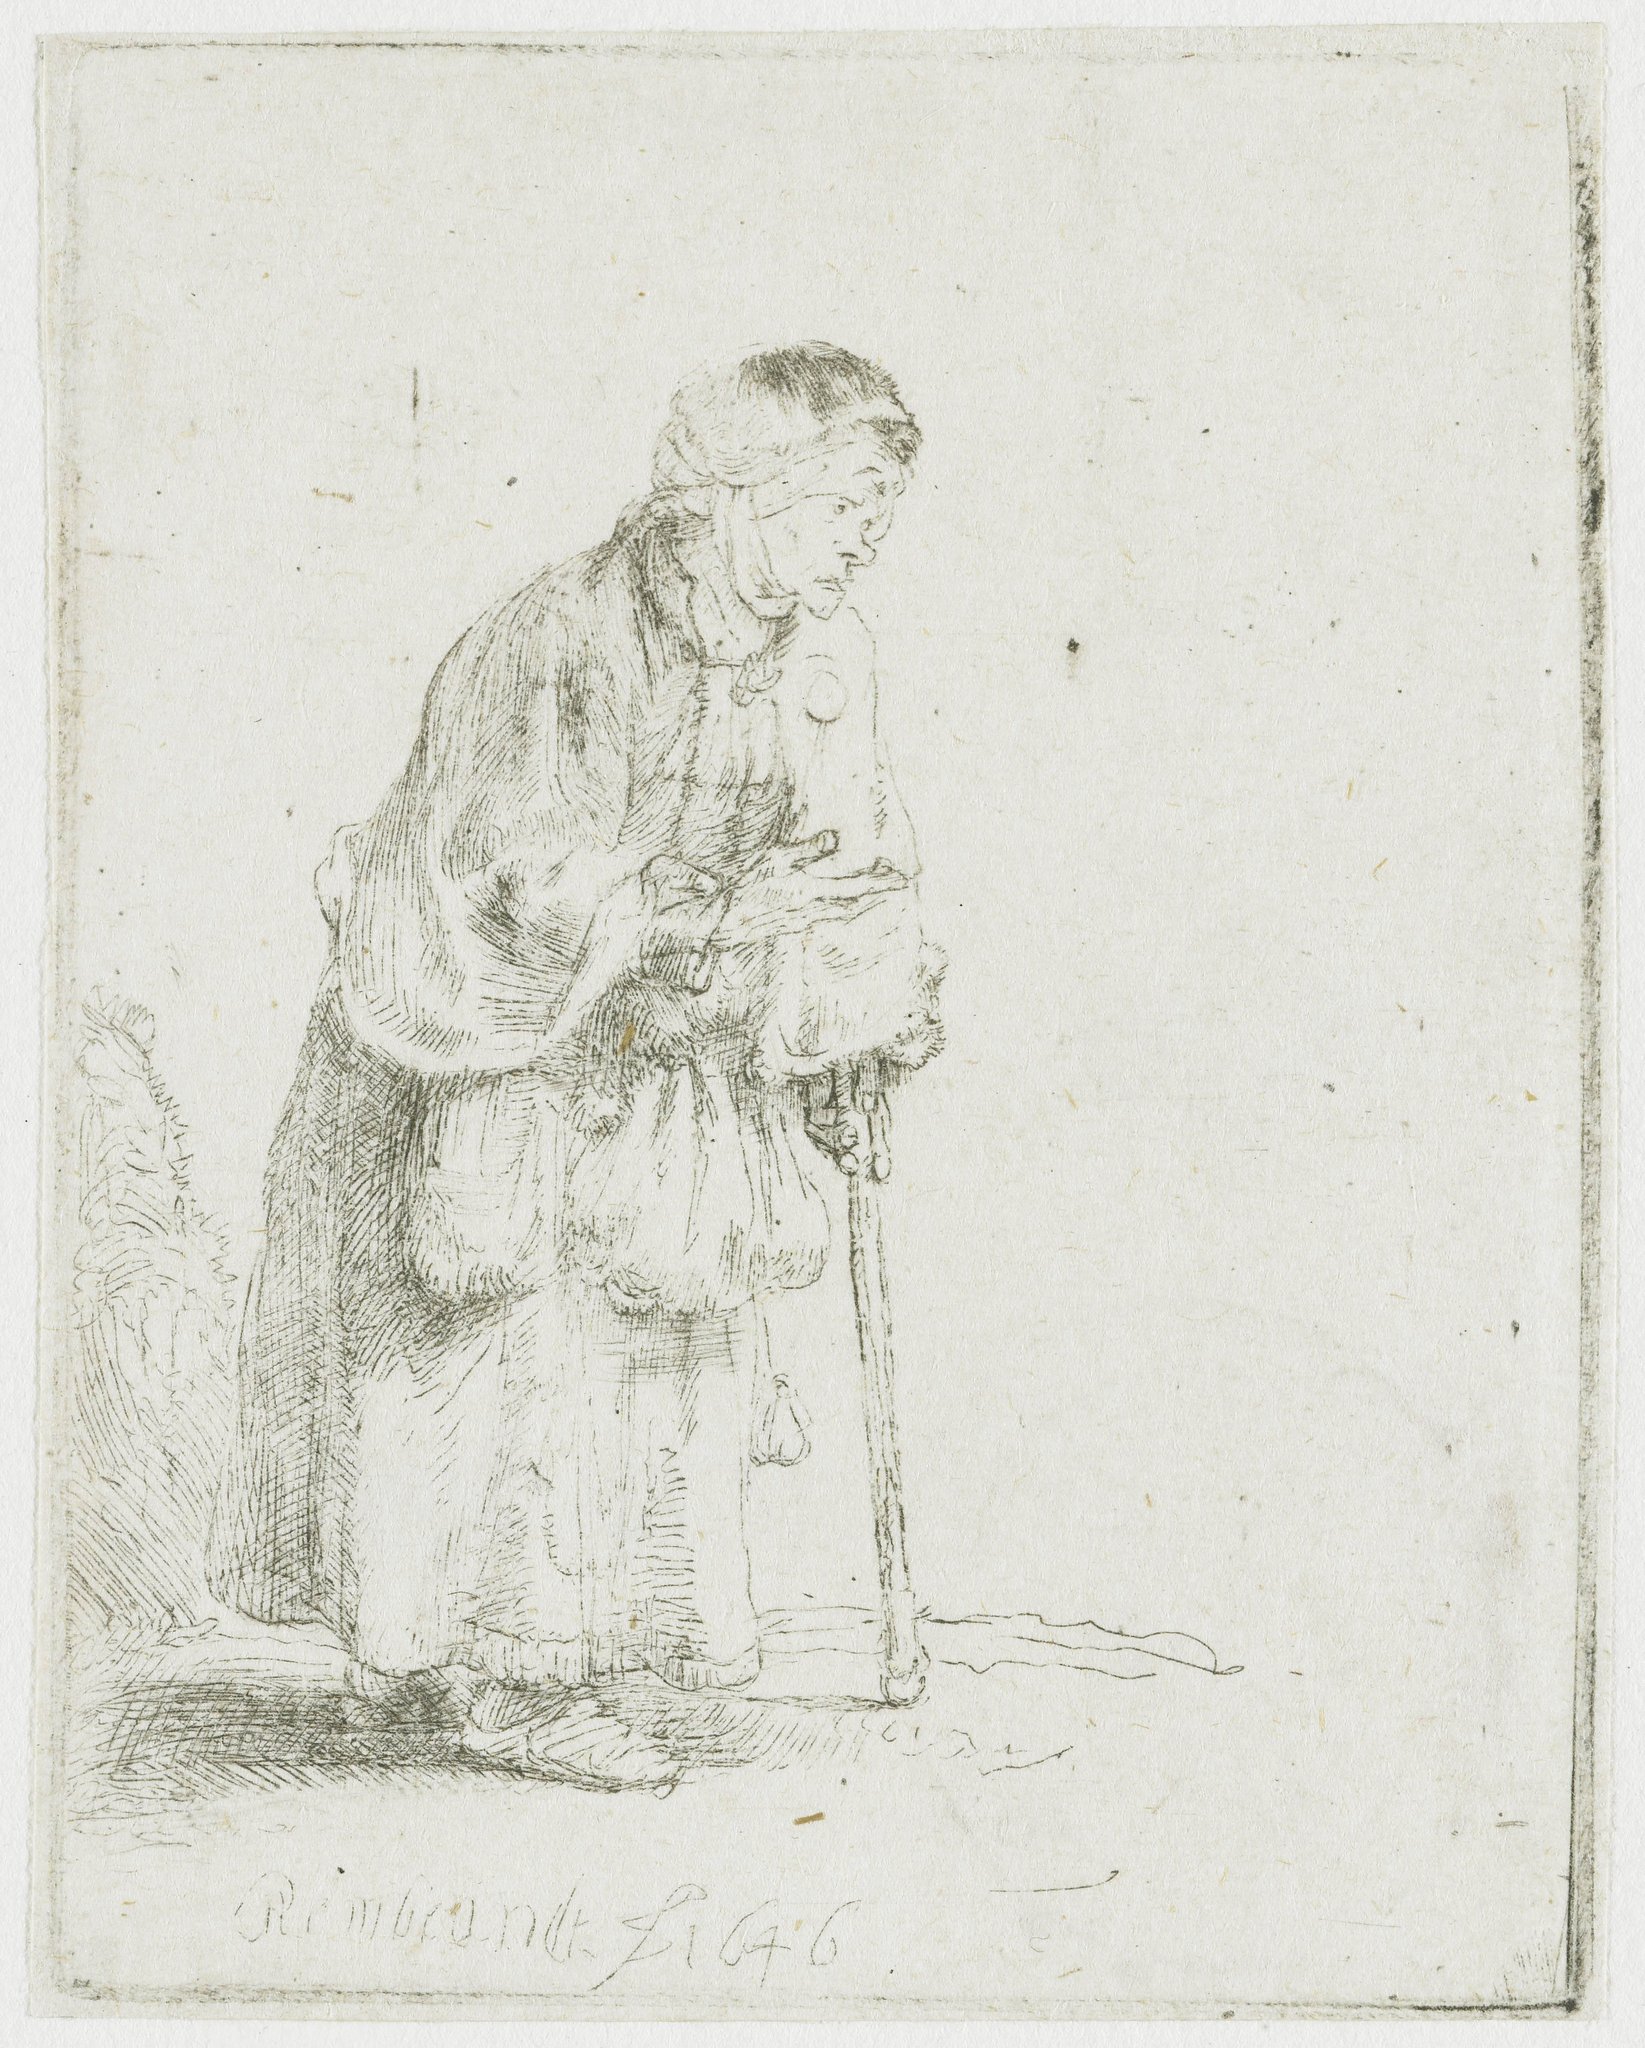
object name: print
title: Beggar woman leaning on a stick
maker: rembrandt van rijn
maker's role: draughtsman, painter, print maker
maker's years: 1606-1669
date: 1646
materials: paper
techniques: drypoint, etching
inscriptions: signature and date: ‘Rembrandt f. 1646’, collector's mark: Lugt 240